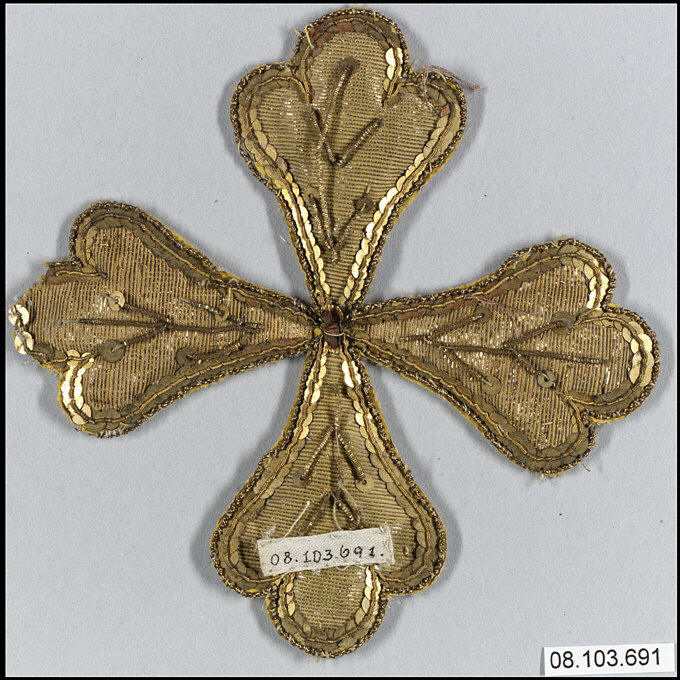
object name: ornament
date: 1801-1833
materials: metal, metal thread